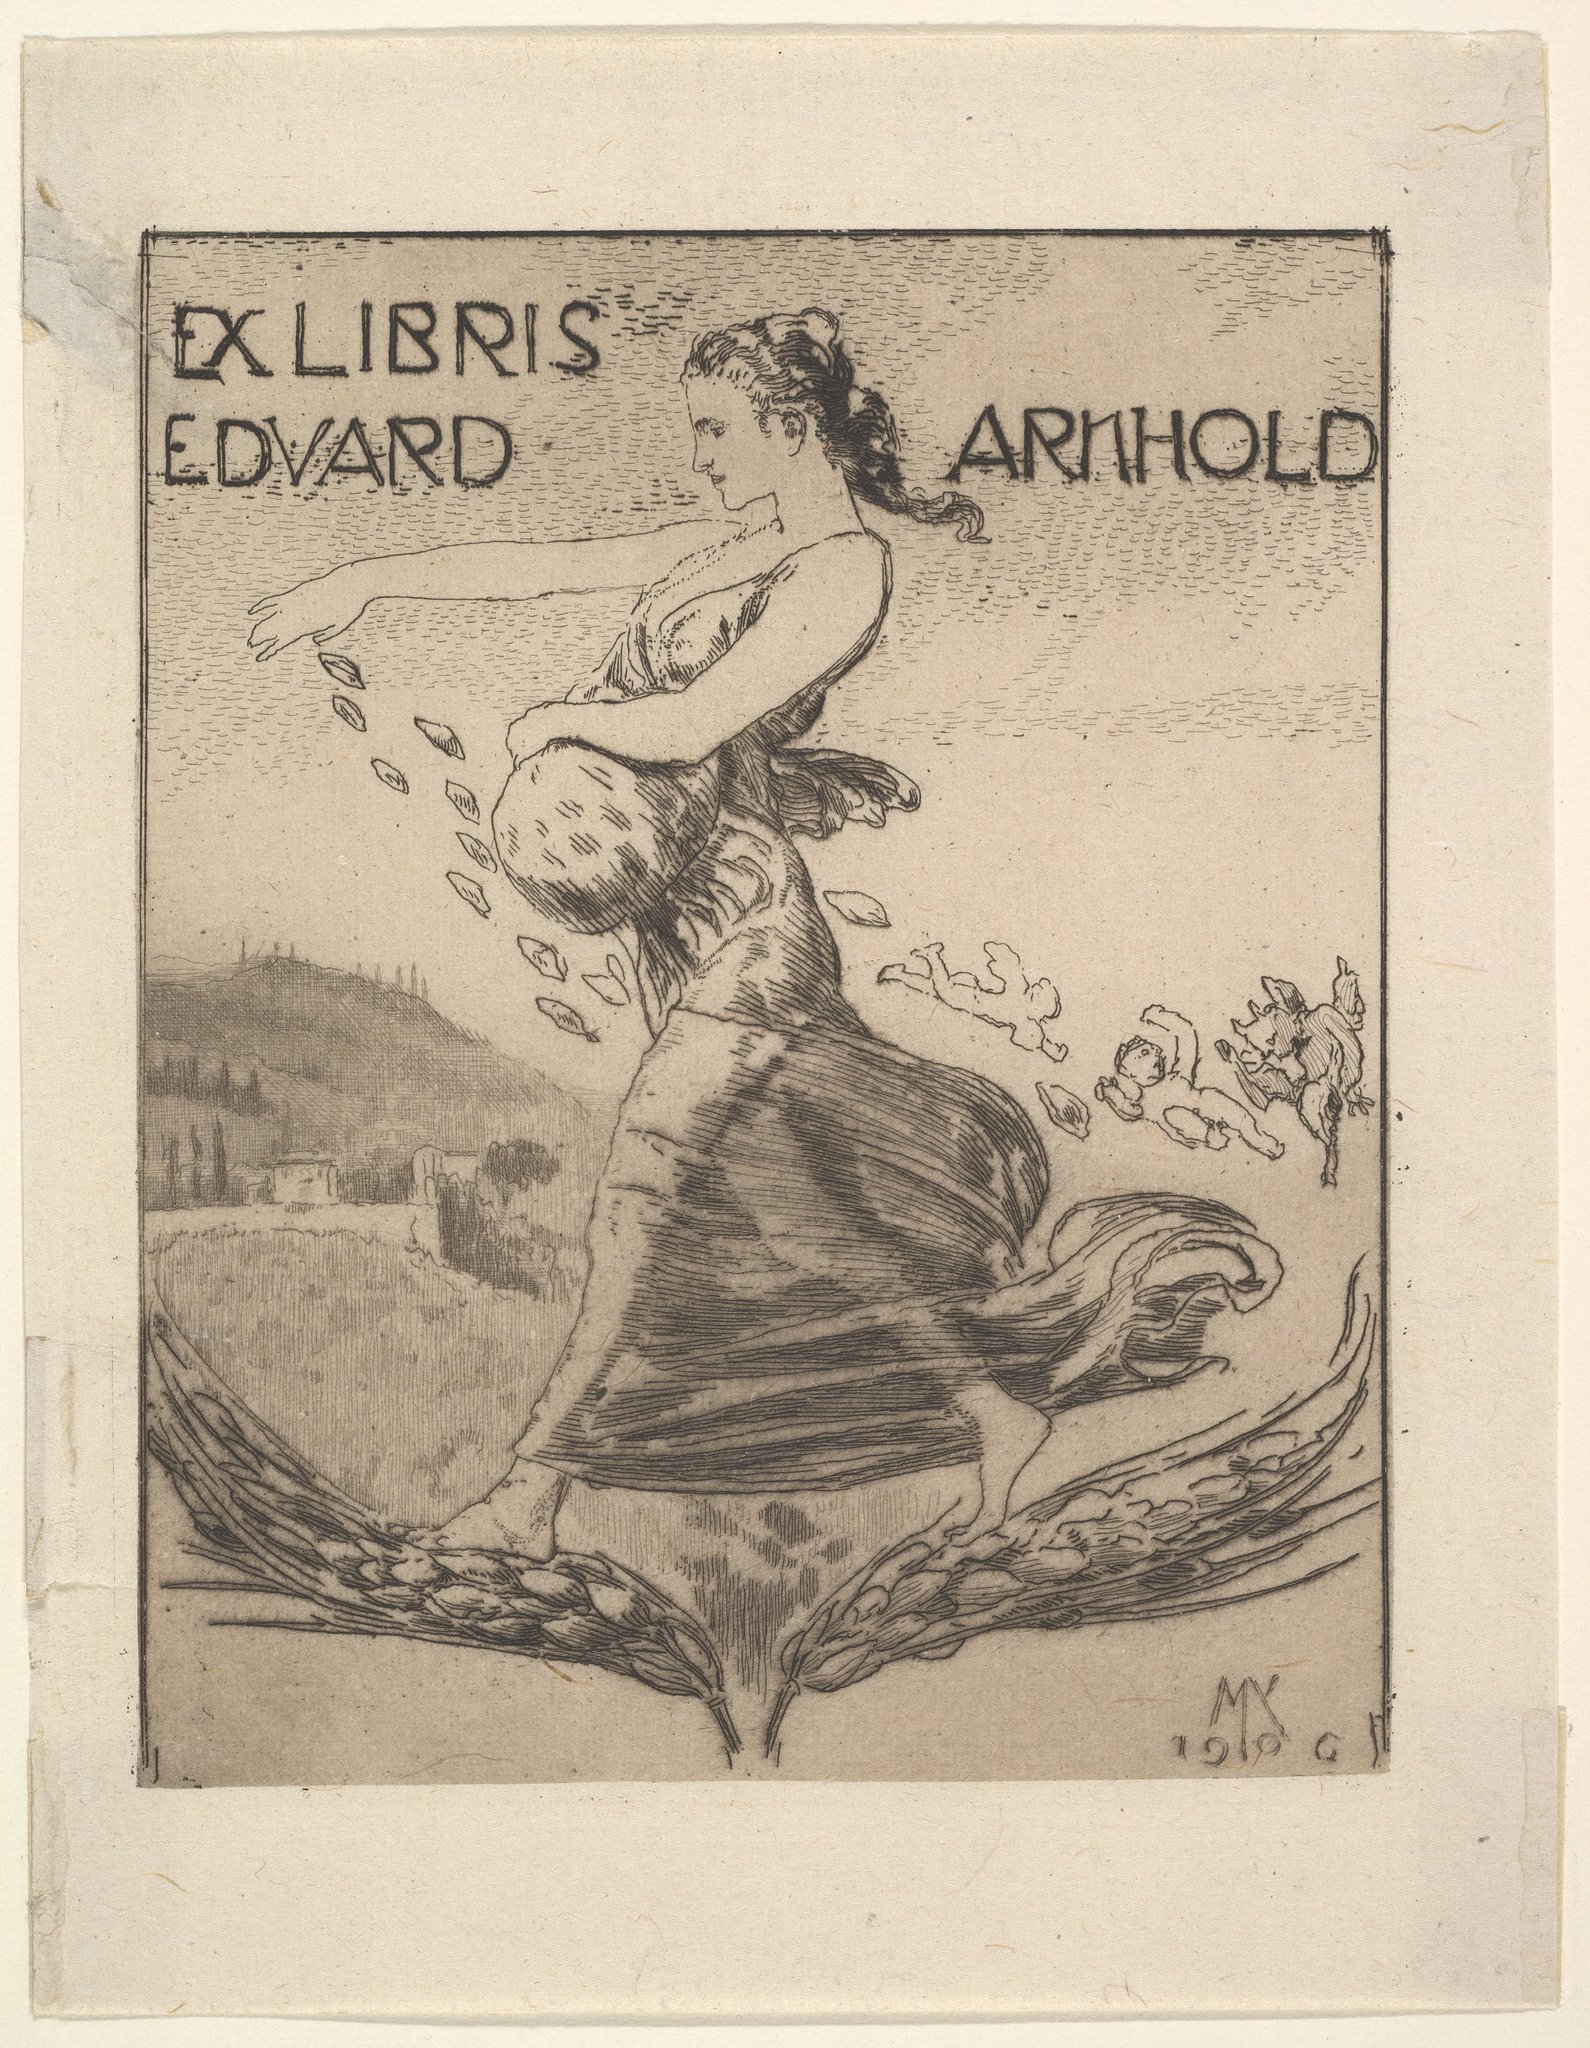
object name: print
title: Ex Libris of Eduard Arnhold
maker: max klinger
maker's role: artist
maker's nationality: german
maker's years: 1857-1920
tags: women